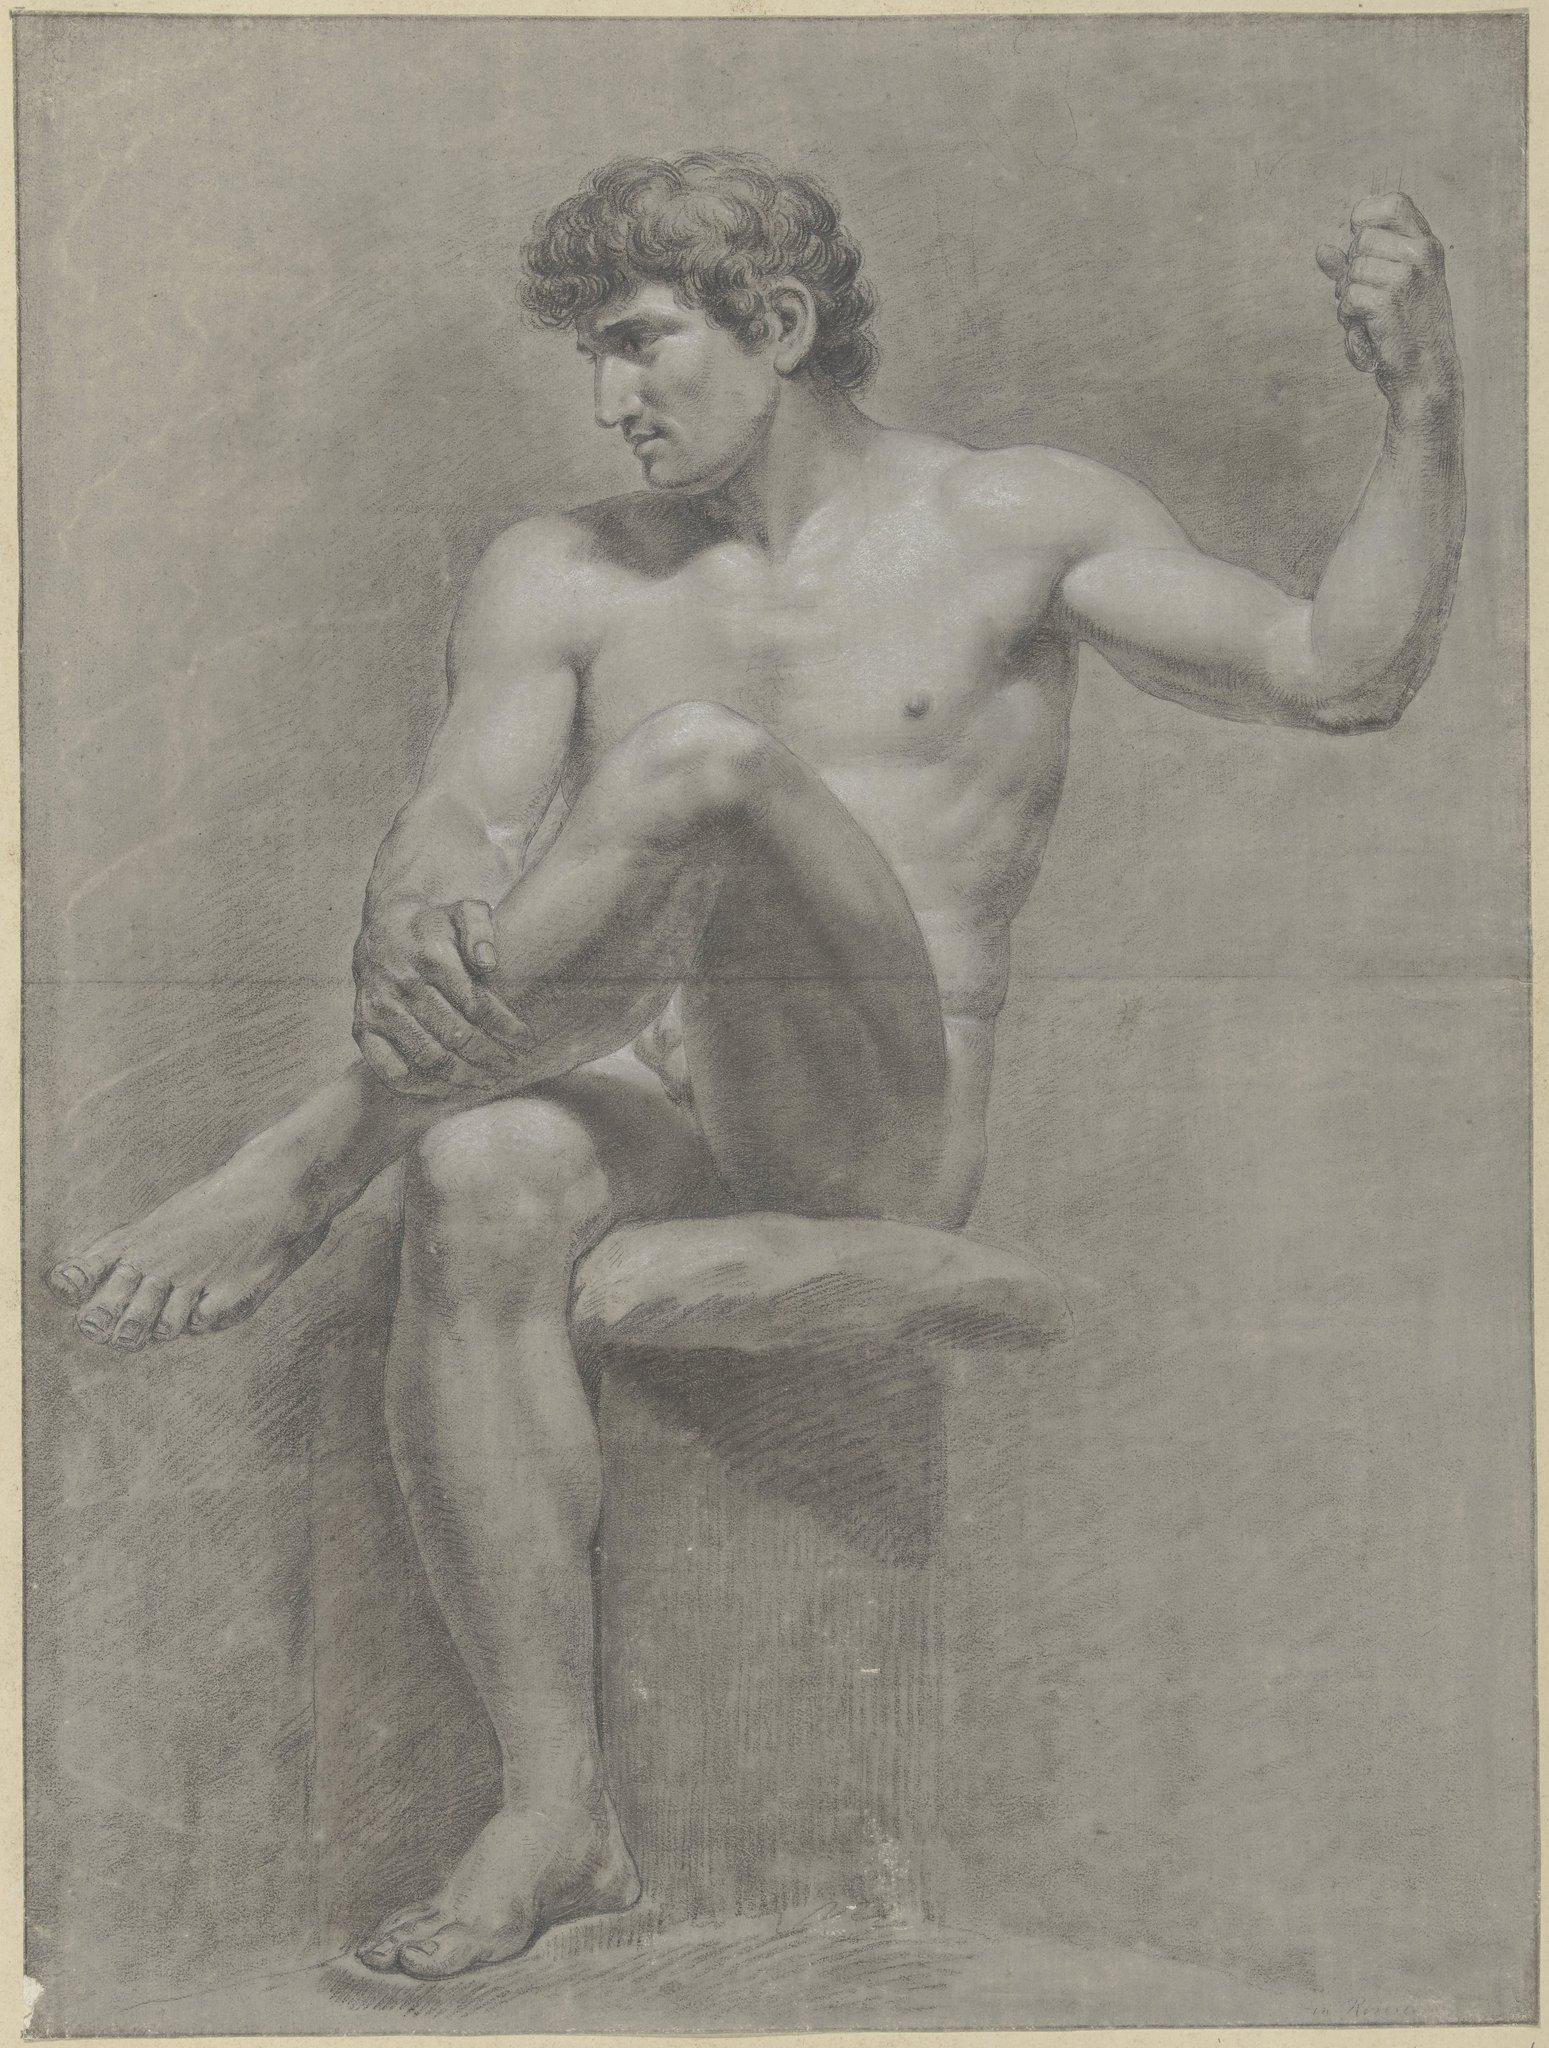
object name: drawing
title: Zittend mannelijk naakt, het linkerbeen op de rechterknie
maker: jean grandjean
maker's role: draughtsman, print maker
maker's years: 1752-1781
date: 1765-1781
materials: chalk, paper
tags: sitting figure